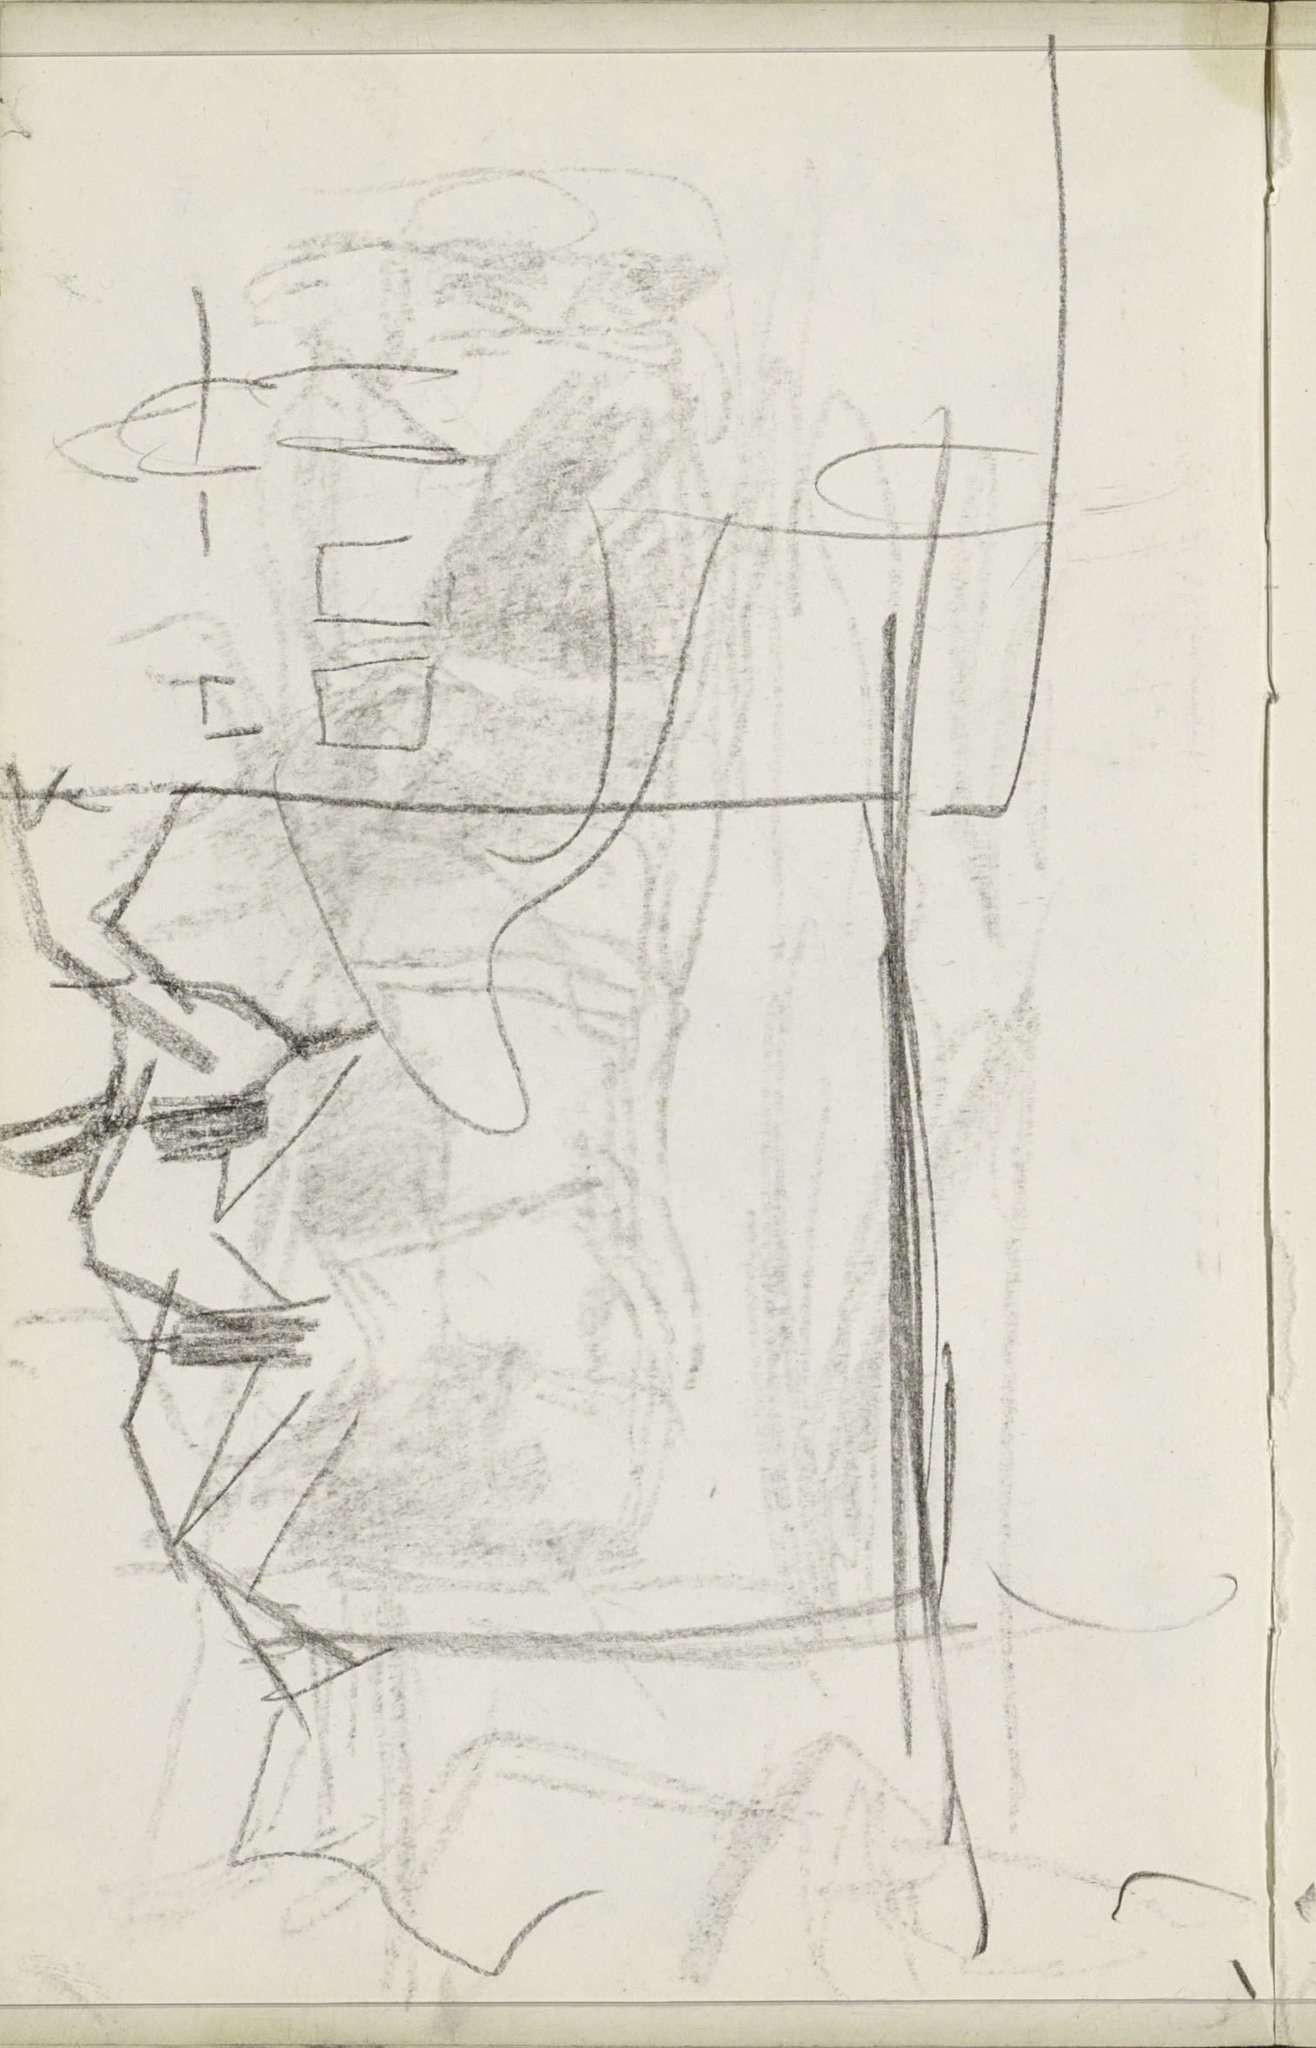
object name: sketchbook leaf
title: Huizenrij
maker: isaac israels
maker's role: draughtsman, painter, print maker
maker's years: 1865-1934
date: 1875-1934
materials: chalk, paper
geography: london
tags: urban housing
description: Pagina 21 en pagina 22 uit schetsboek XXXV met 36 pagina's.